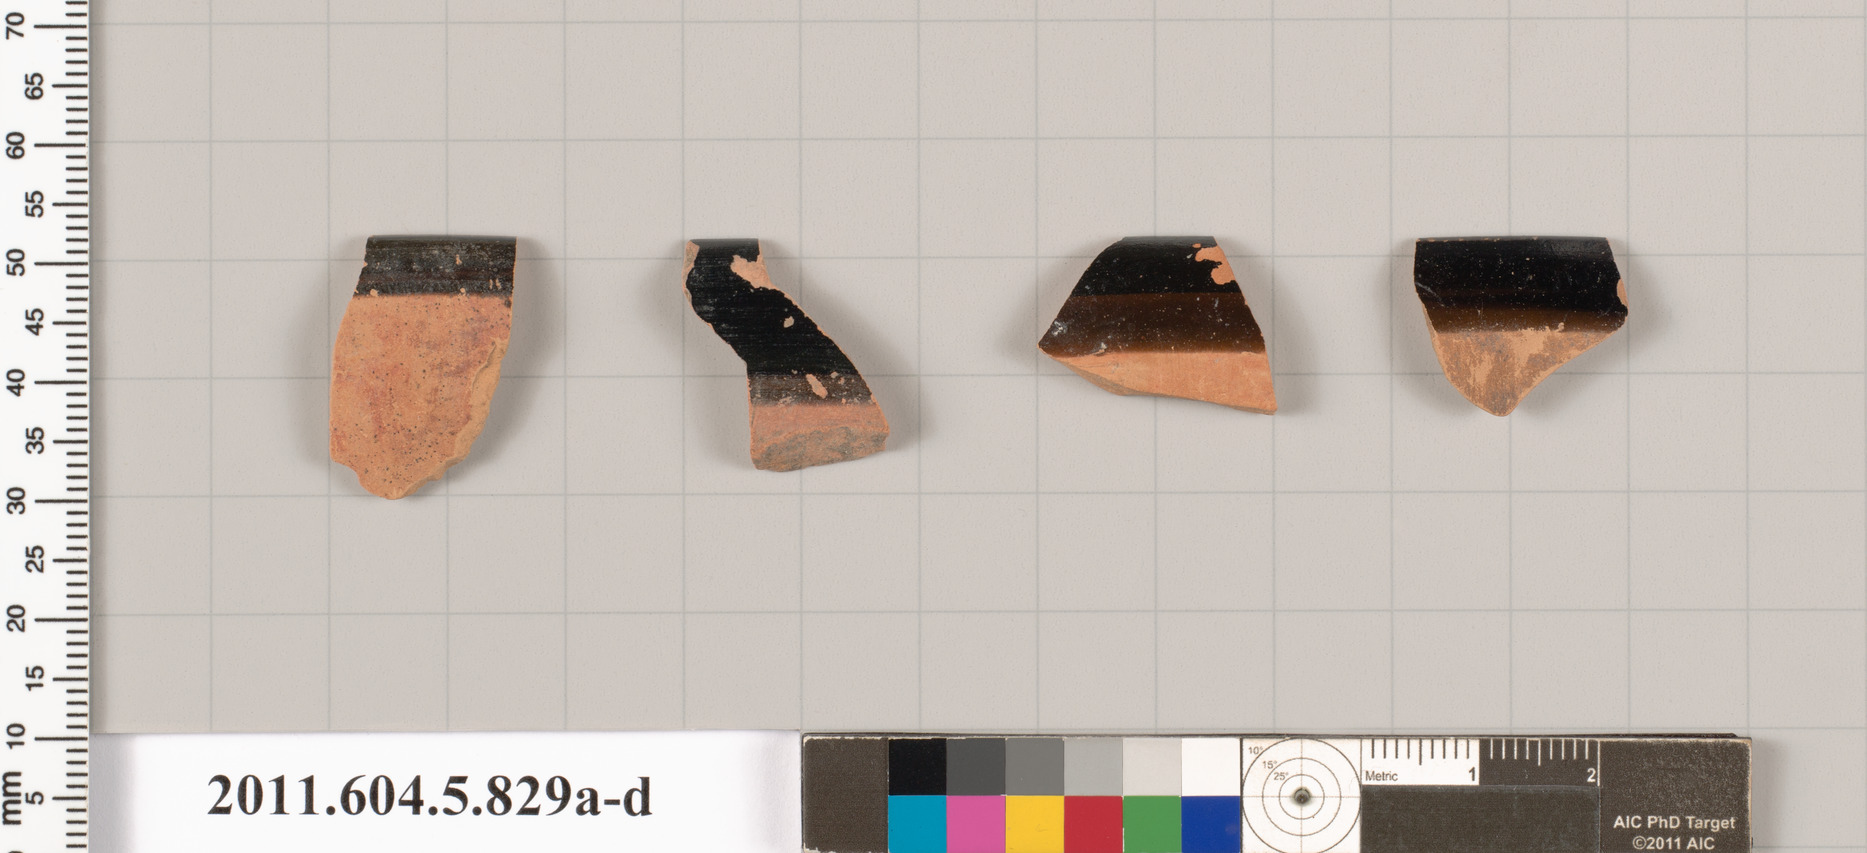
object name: kylix fragment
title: Terracotta rim fragments of kylikes (drinking cups)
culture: greek, attic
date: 600-401 BCE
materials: terracotta